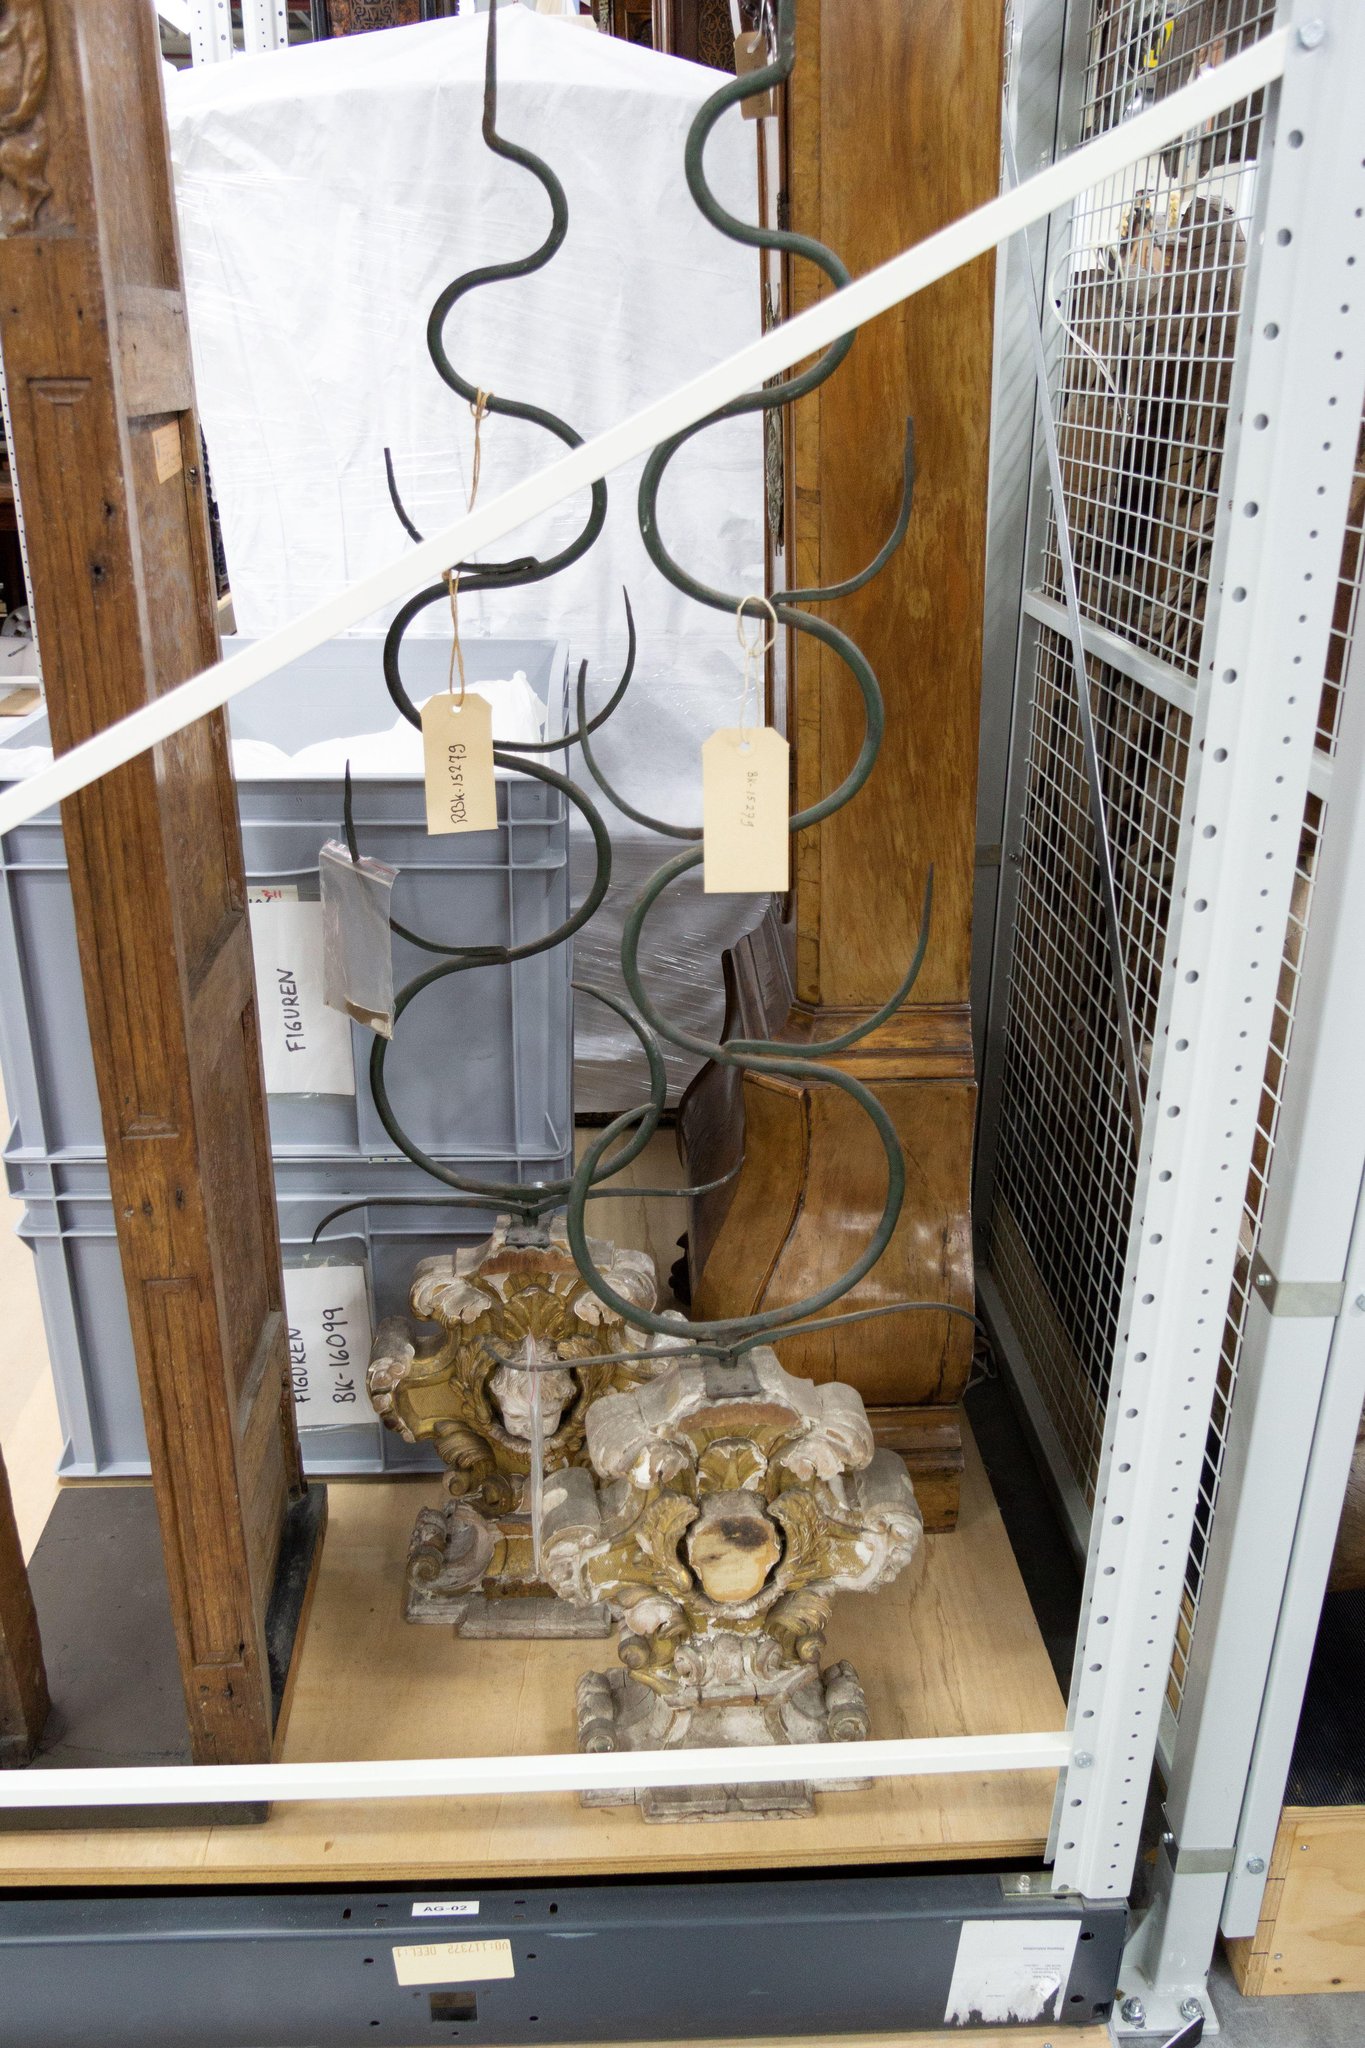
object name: betimmering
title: Deel van een betimmering behorend bij een trap in vroege Marot-stijl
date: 1680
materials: copper, wood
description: Deel van een betimmering behorend bij een trap in vroege Marot-stijl.